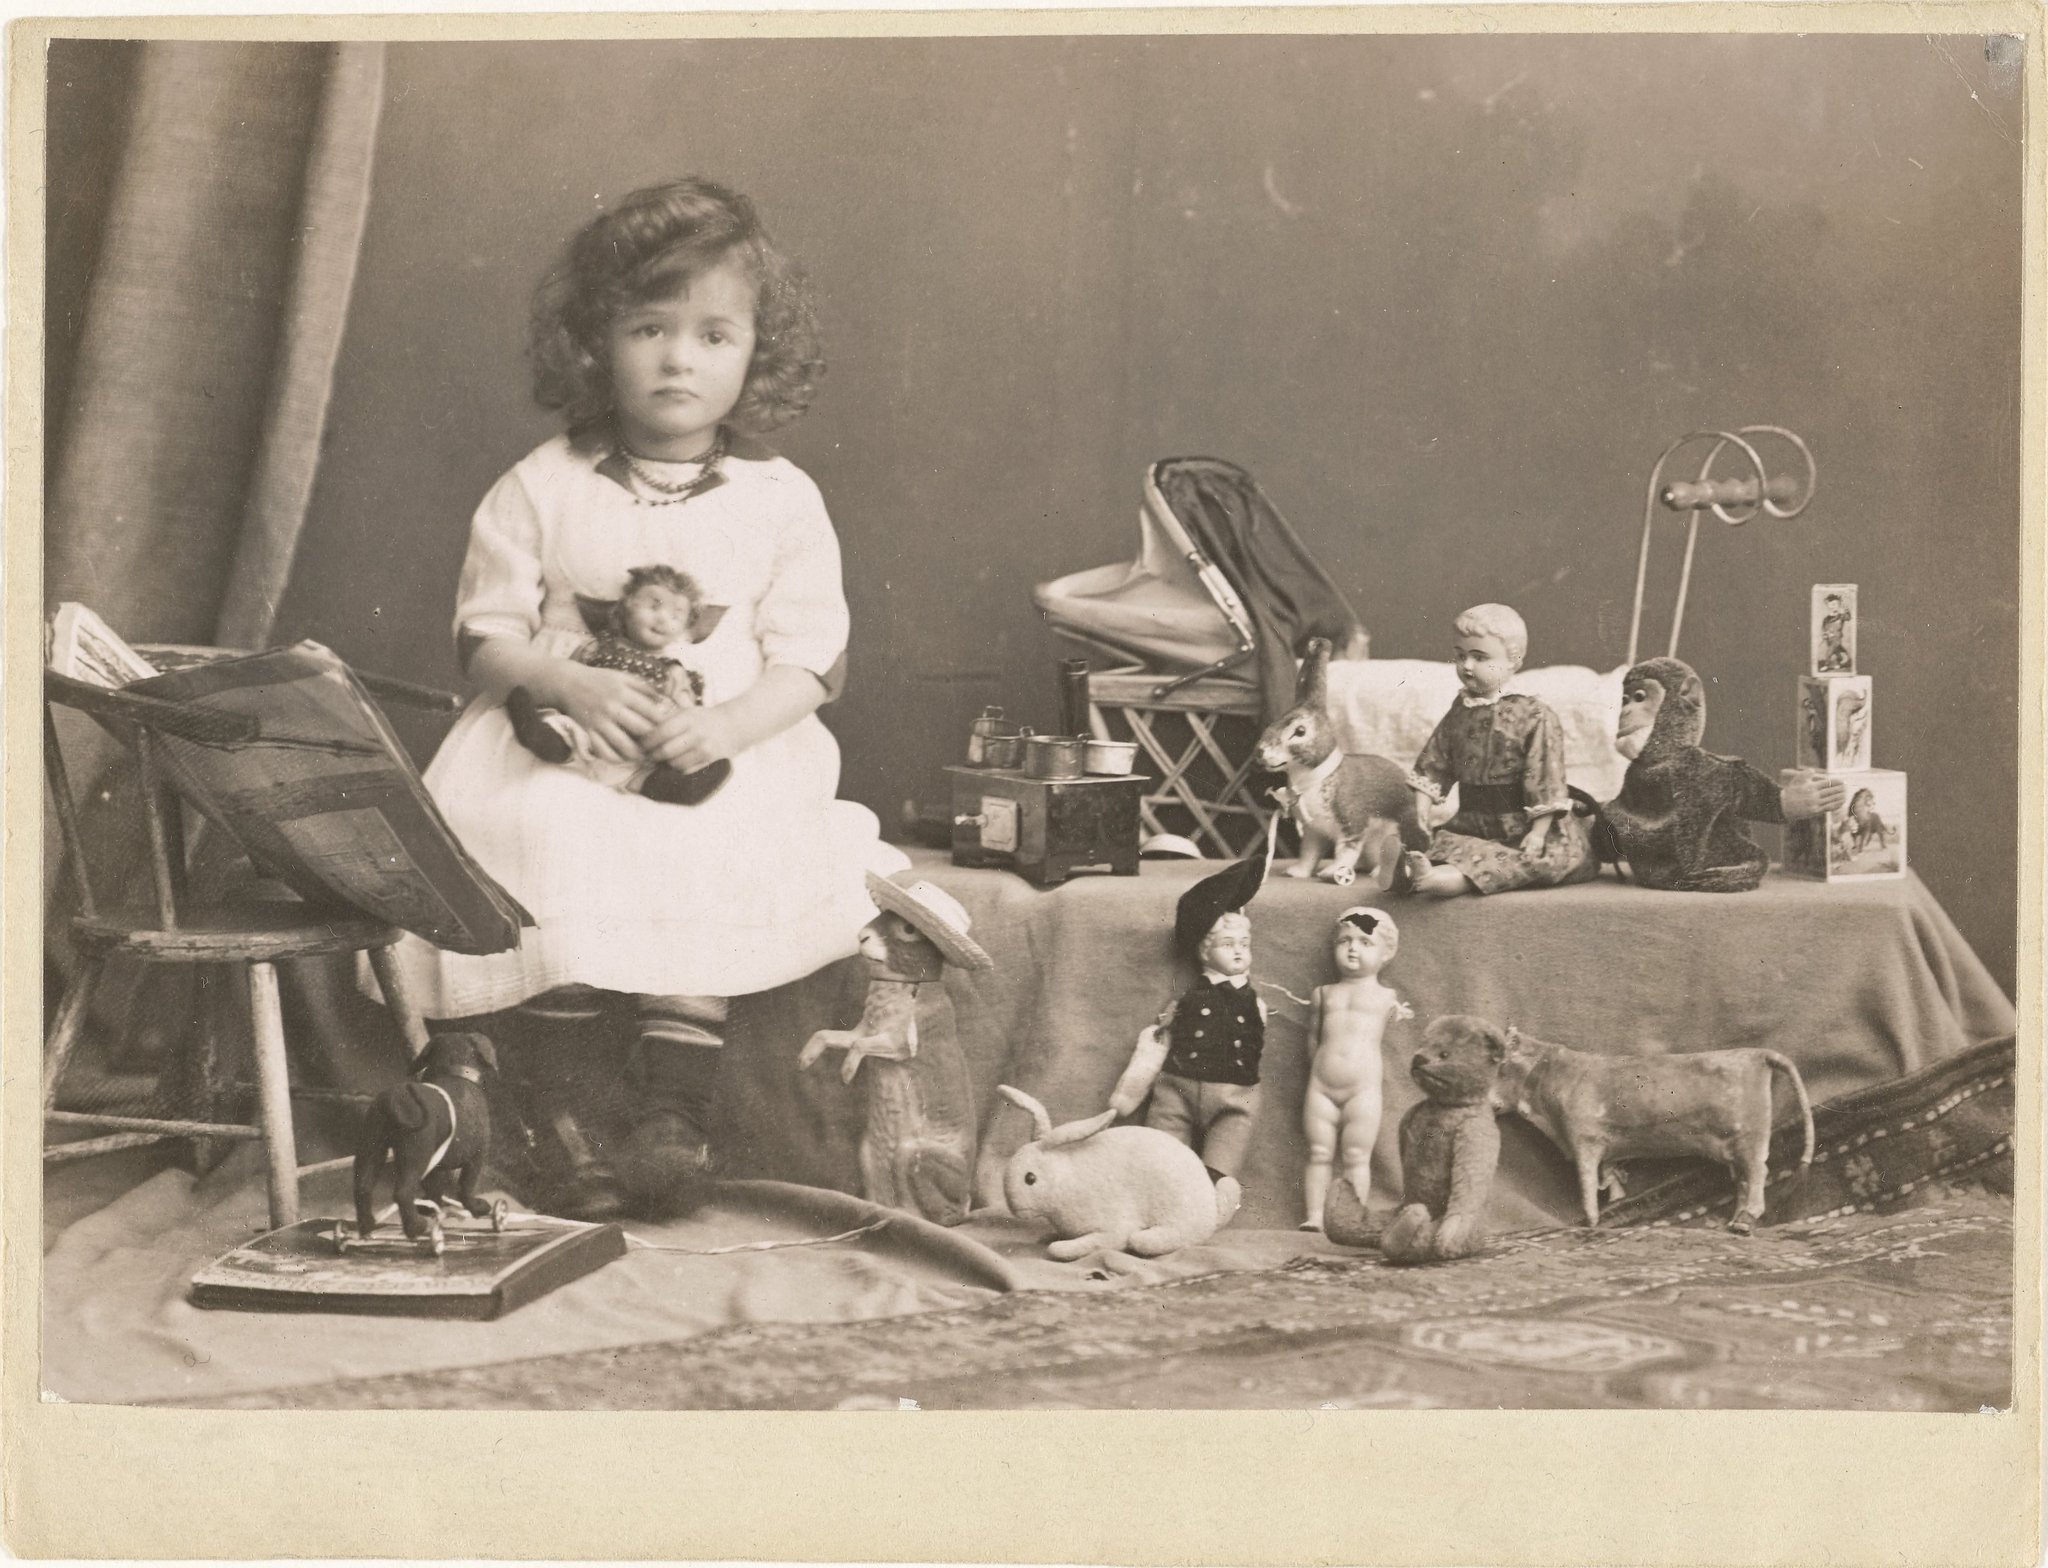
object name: photograph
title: Marba Titzenthaler, dochter van de fotograaf, met haar speelgoed in het woonhuis in de Friedrichsstrasse, Berlijn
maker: waldemar titzenthaler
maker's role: fotograaf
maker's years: 1869-1937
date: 1914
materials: paper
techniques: gelatin silver print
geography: berlin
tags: girl (child between toddler and youth), (playing with) toys, berlin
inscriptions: date: ‘17.5.14.’